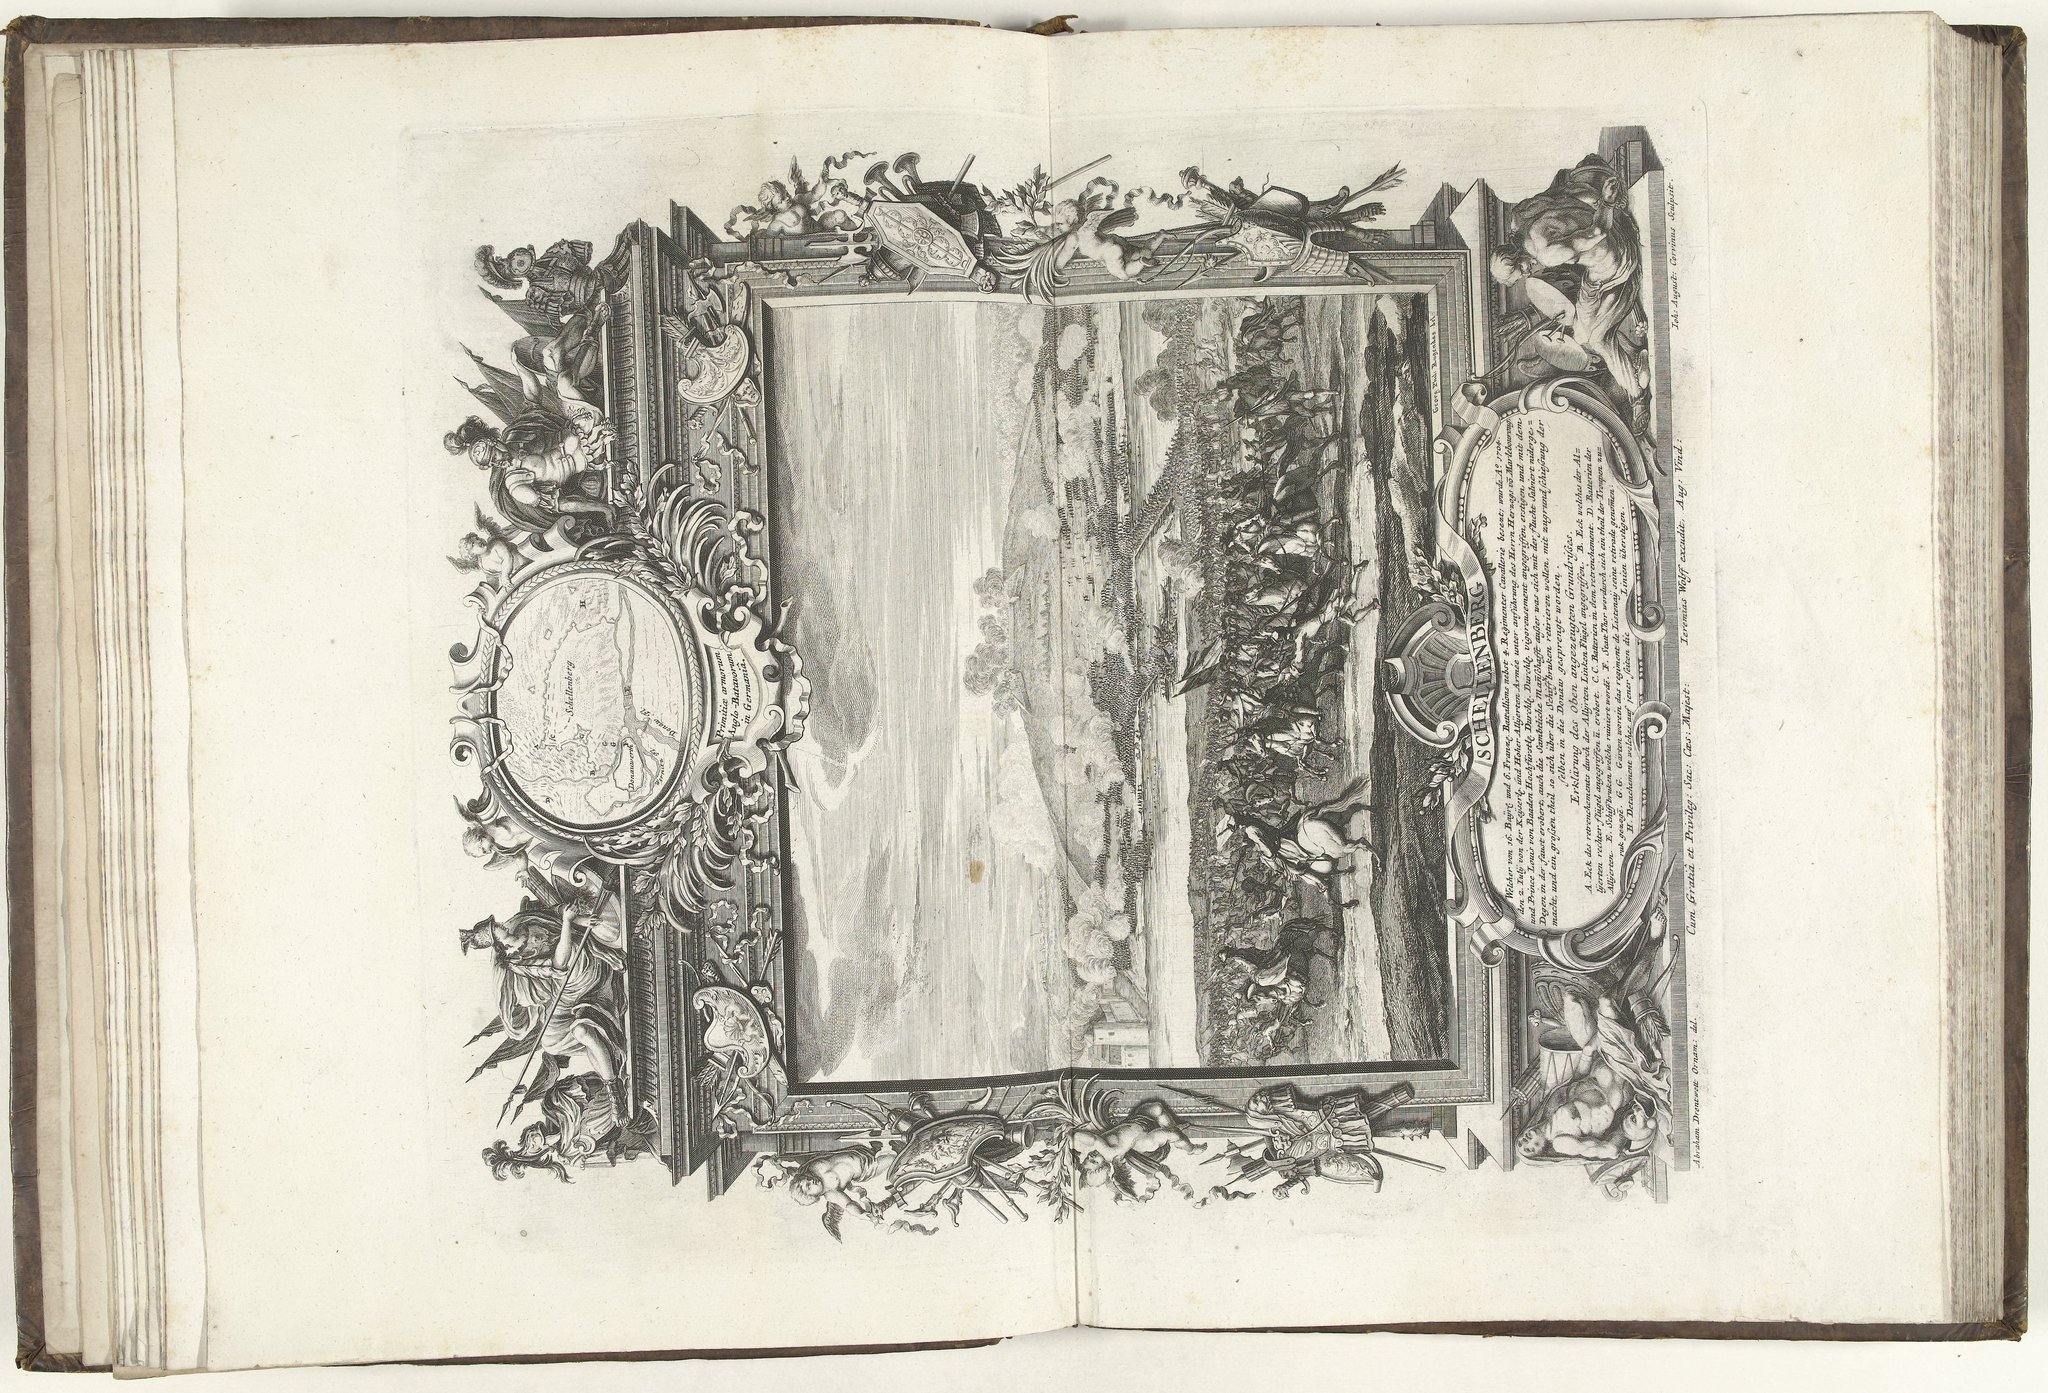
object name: history print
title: Verovering van Schellenberg, 1704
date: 1712-1715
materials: paper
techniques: engraving, etching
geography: augsburg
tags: battle (+ land forces)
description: Verovering van het Fort Schellenberg aan de Donau. Overwinning van de Geallieerden op de Fransen en Beiersen, 2 juli 1704. Voorstelling in een rijk versierde ornamentele omlijsting met met bovenaan een plattegrond van de stad. Onderaan in het midden tussen overwonnen en geketende vijanden een cartouche met een beschrijving van de gevechten in het Duits. Blad in de gebonden verzameling platen uitgebracht onder de titel: Repraesentatio belli ... Der Spanische Successions-Krieg [ca. 1720].